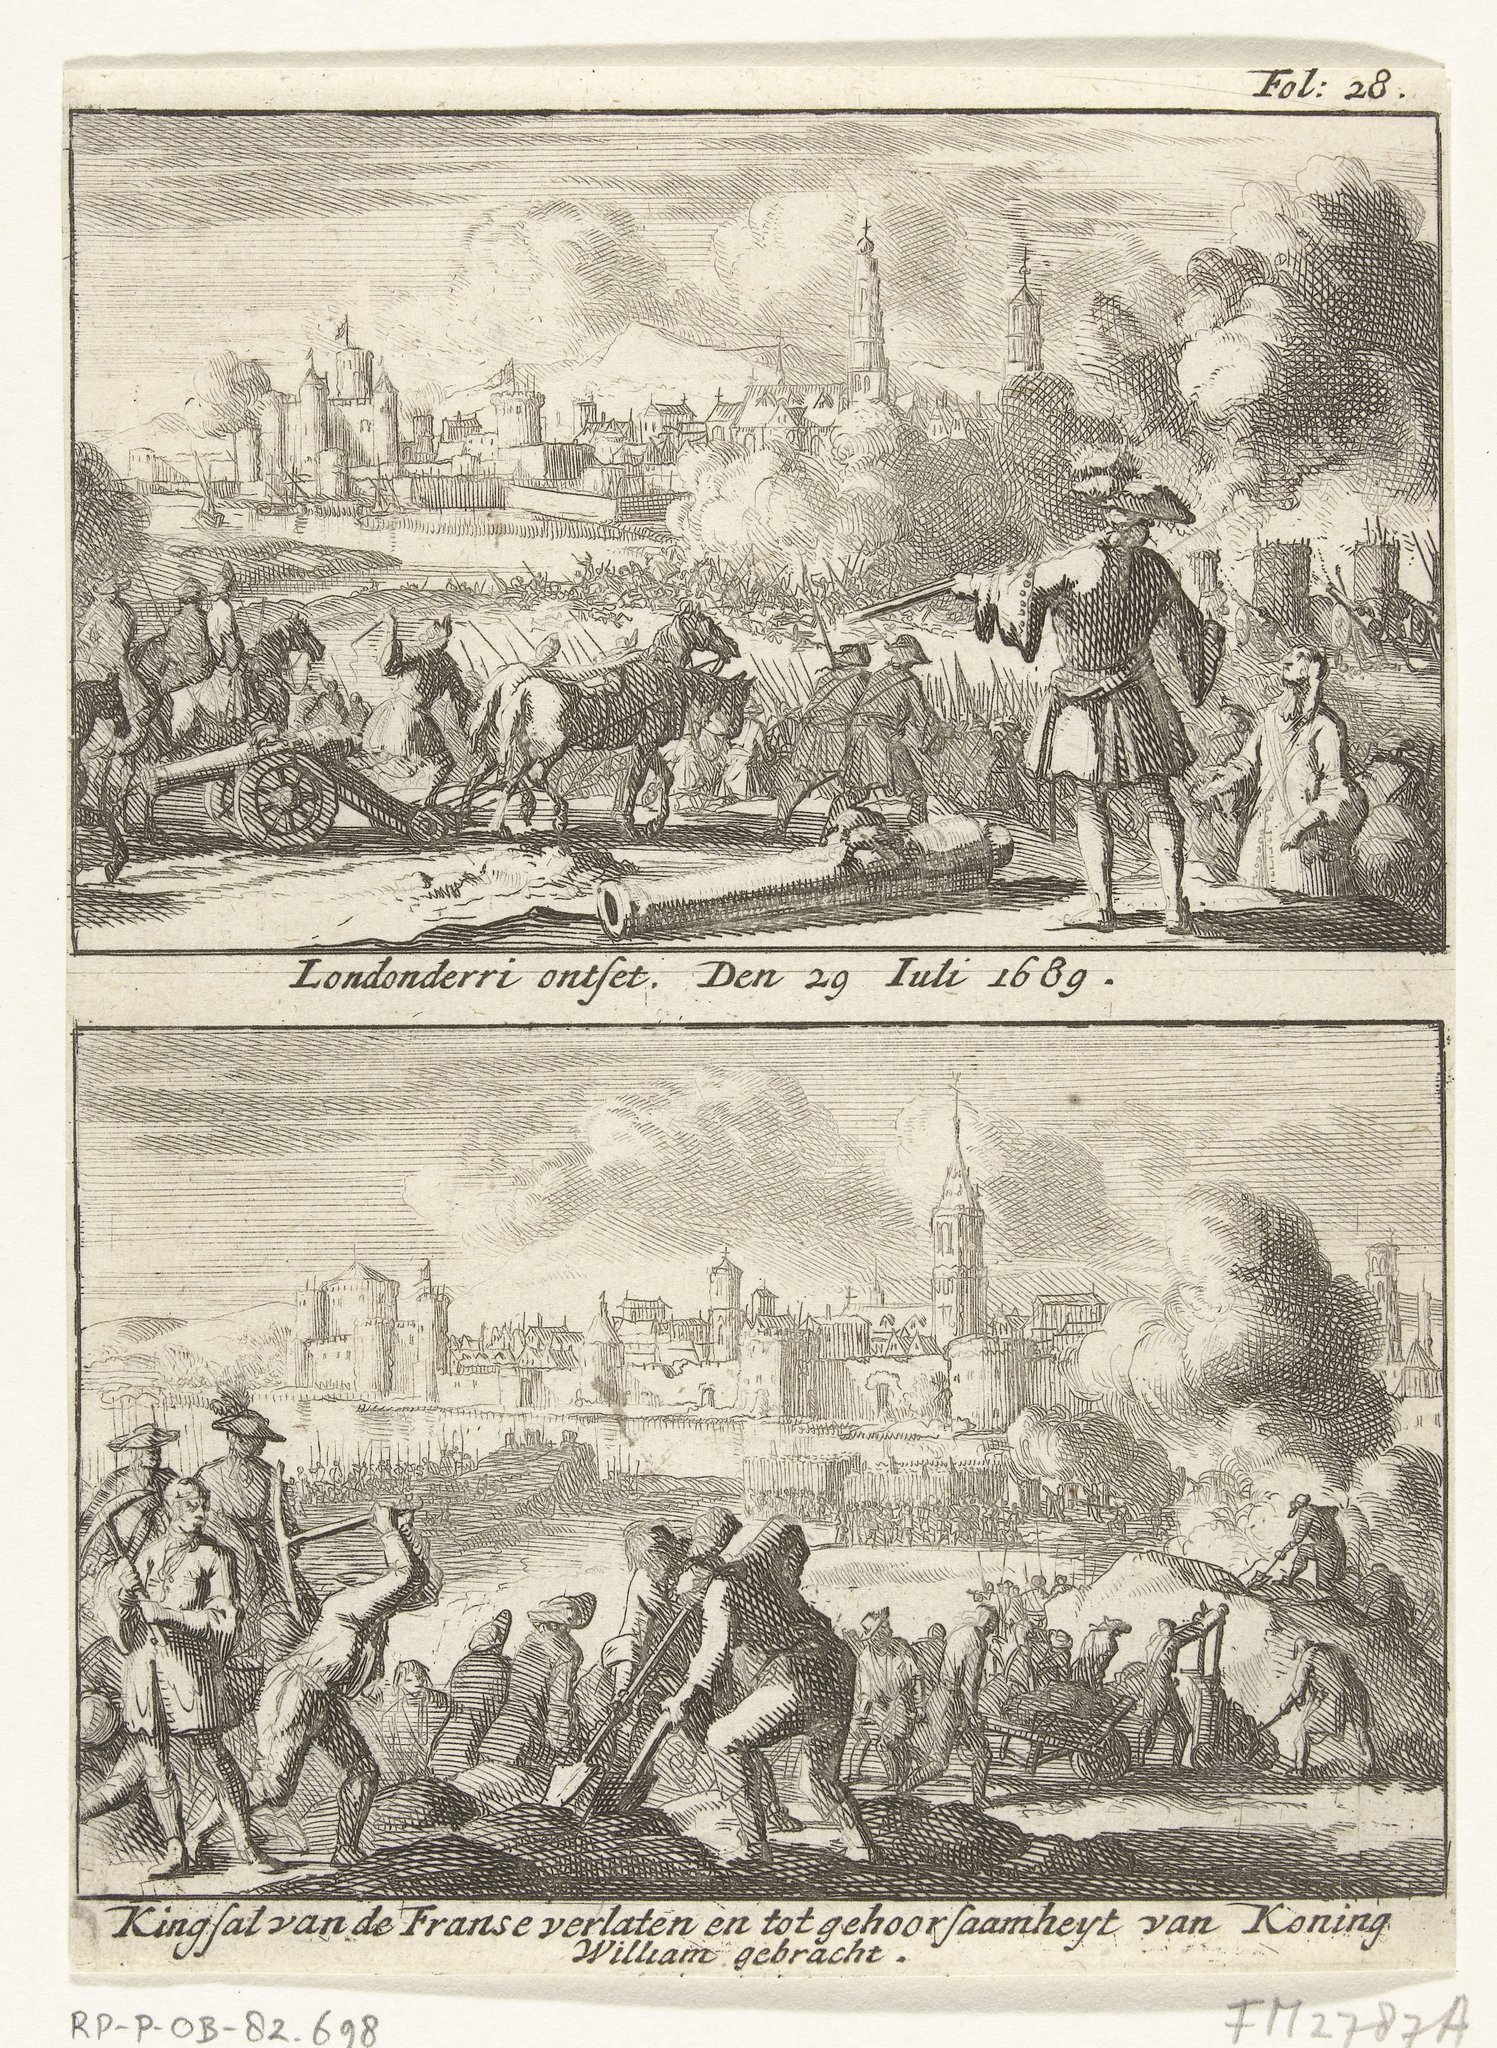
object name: print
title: Londonderri ontset. Den 29 Juli 1689 / Kingsal van de Franse verlaten en tot gehoorsaamheyt van Koning William gebrachte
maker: jan luyken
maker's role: draughtsman, print maker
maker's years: 1649-1712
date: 1689-1690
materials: paper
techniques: engraving, etching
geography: northern netherlands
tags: jacobus ii (koning van engeland en schotland), william iii (prince of orange and king of england, scotland, and ireland), siege, position war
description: Blad met twee voorstellingen van de strijd tussen de legers van Willem III en Jacobus II in Ierland. Boven het ontzet van Londonderry op 28 juli 1689 na tevergeefs vanaf 18 april door het leger van koning Jacobus II belegerd te zijn geweest. Onder Kinsale wordt verlaten door de Franse troepen, 1689-1690. Rechtsboven gemerkt: Fol: 28.